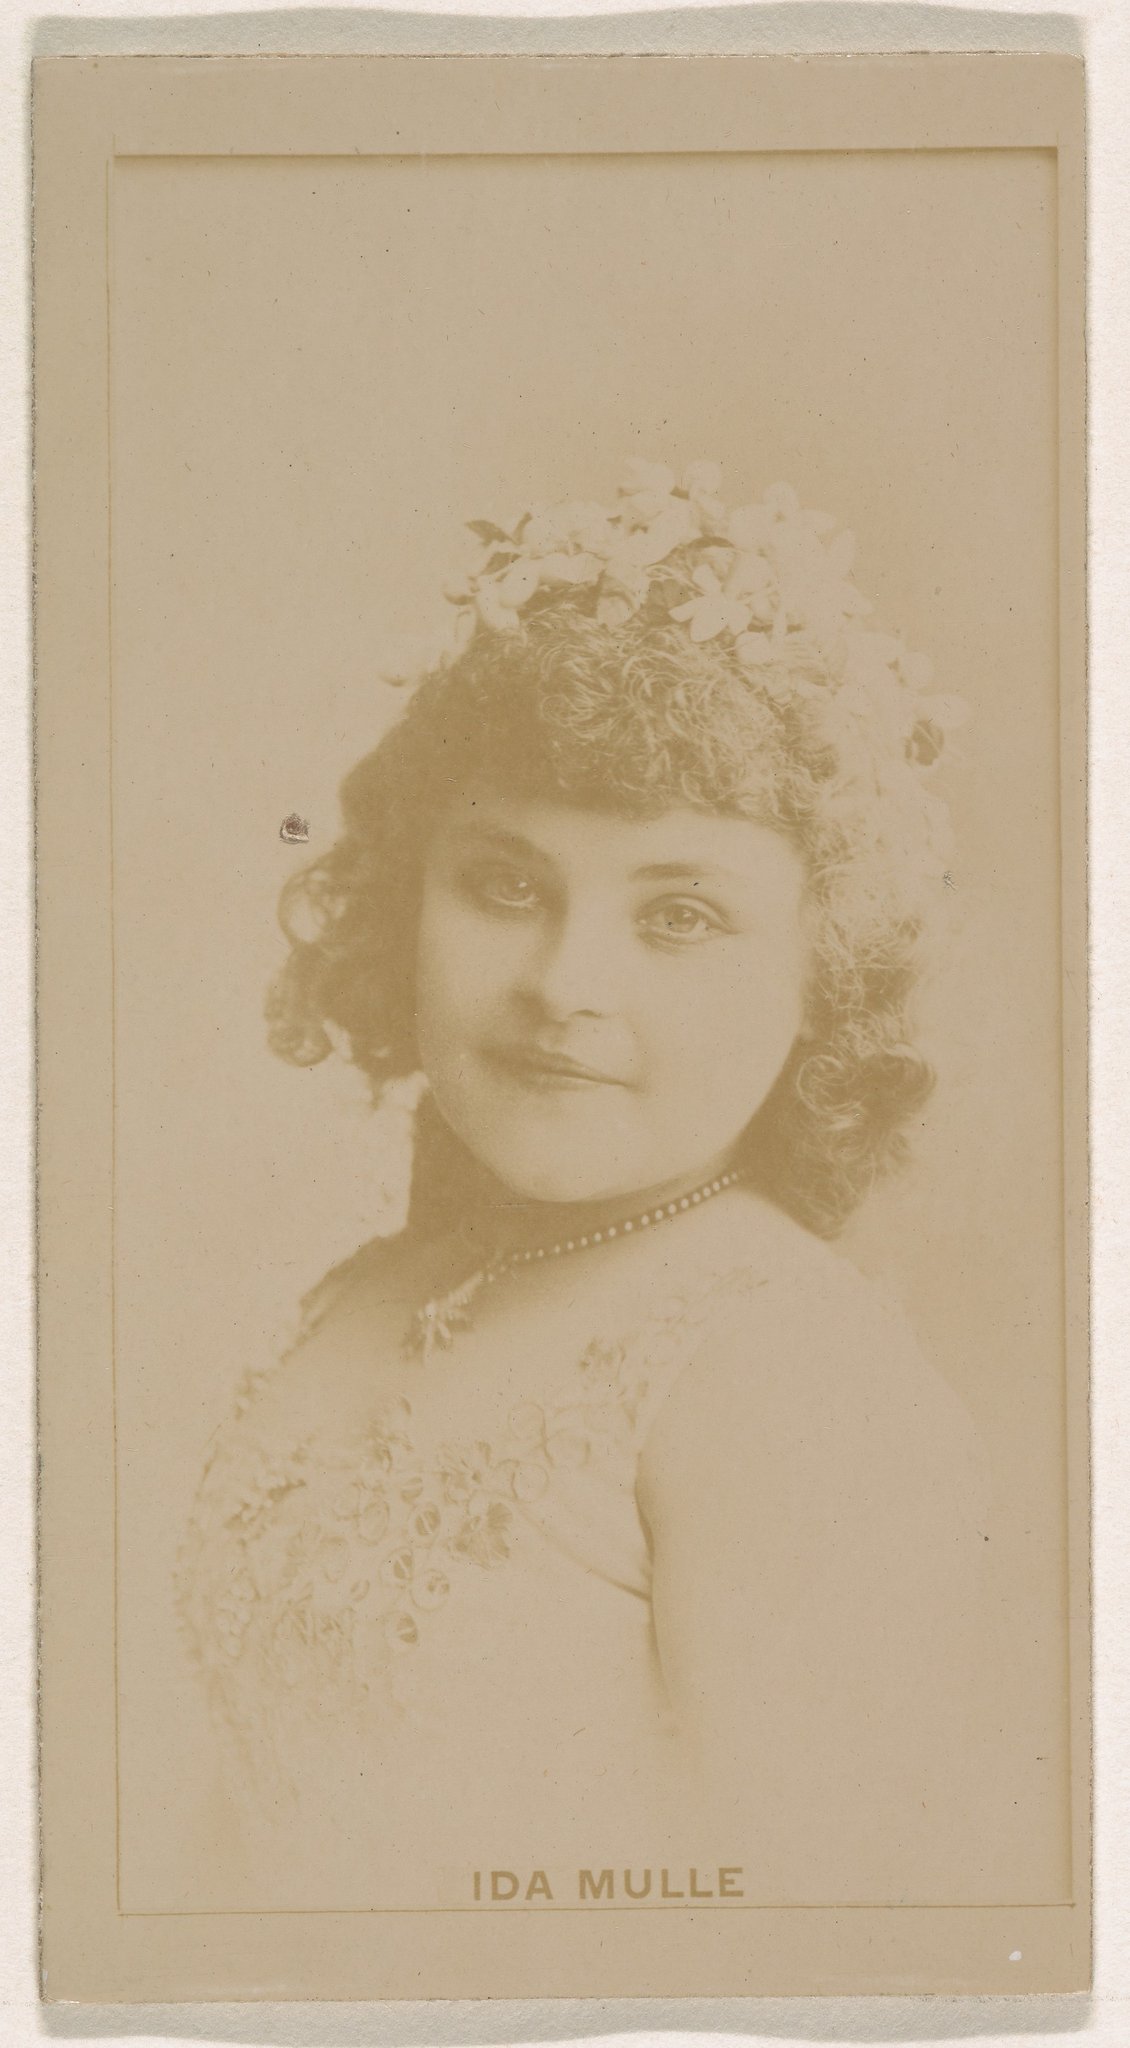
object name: photograph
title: Ida Mulle, from the Actresses series (N245) issued by Kinney Brothers to promote Sweet Caporal Cigarettes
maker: kinney brothers tobacco company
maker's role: publisher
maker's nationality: american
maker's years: 1869-2011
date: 1890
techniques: albumen silver print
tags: portraits,women,actresses